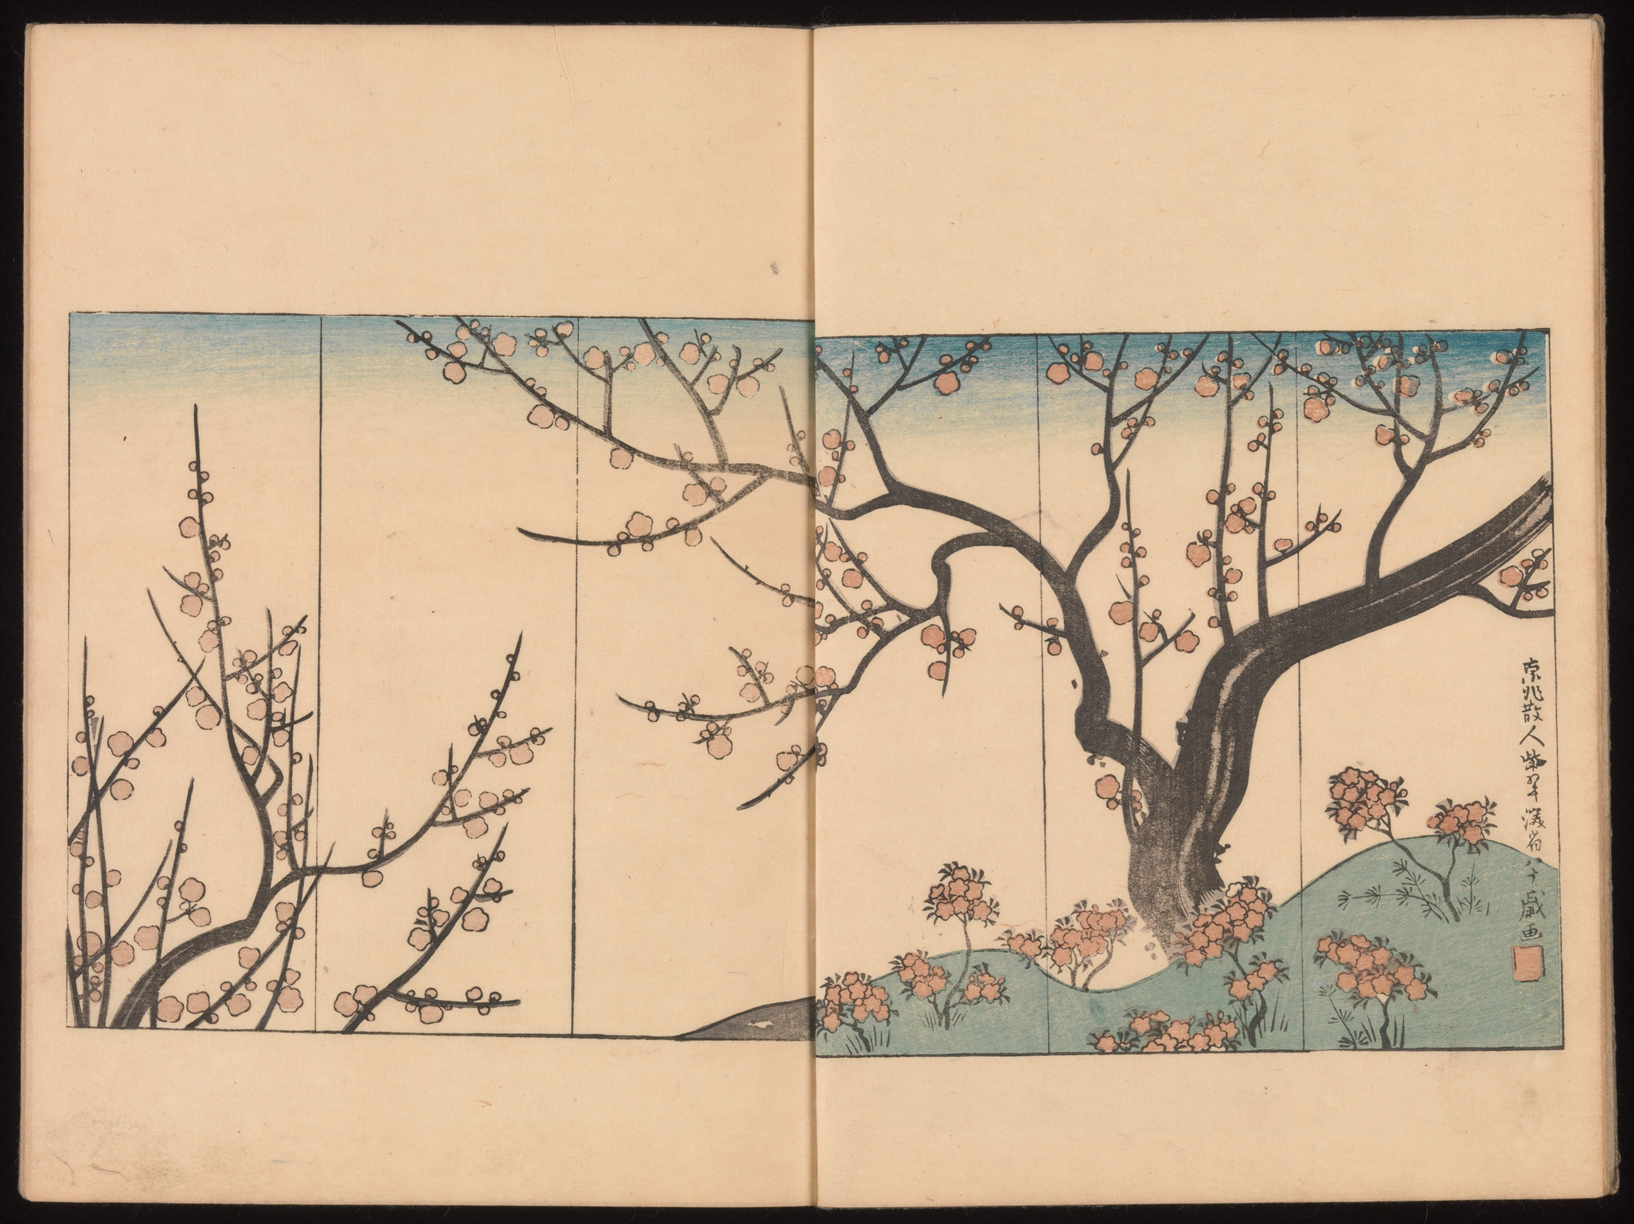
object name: illustrated book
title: Ink Traces of Kenzan (Kenzan iboku)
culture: japanese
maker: sakai hōitsu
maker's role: artist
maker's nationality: japanese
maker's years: 1761-1828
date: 1823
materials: ink, paper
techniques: woodblock print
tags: deer,flowers